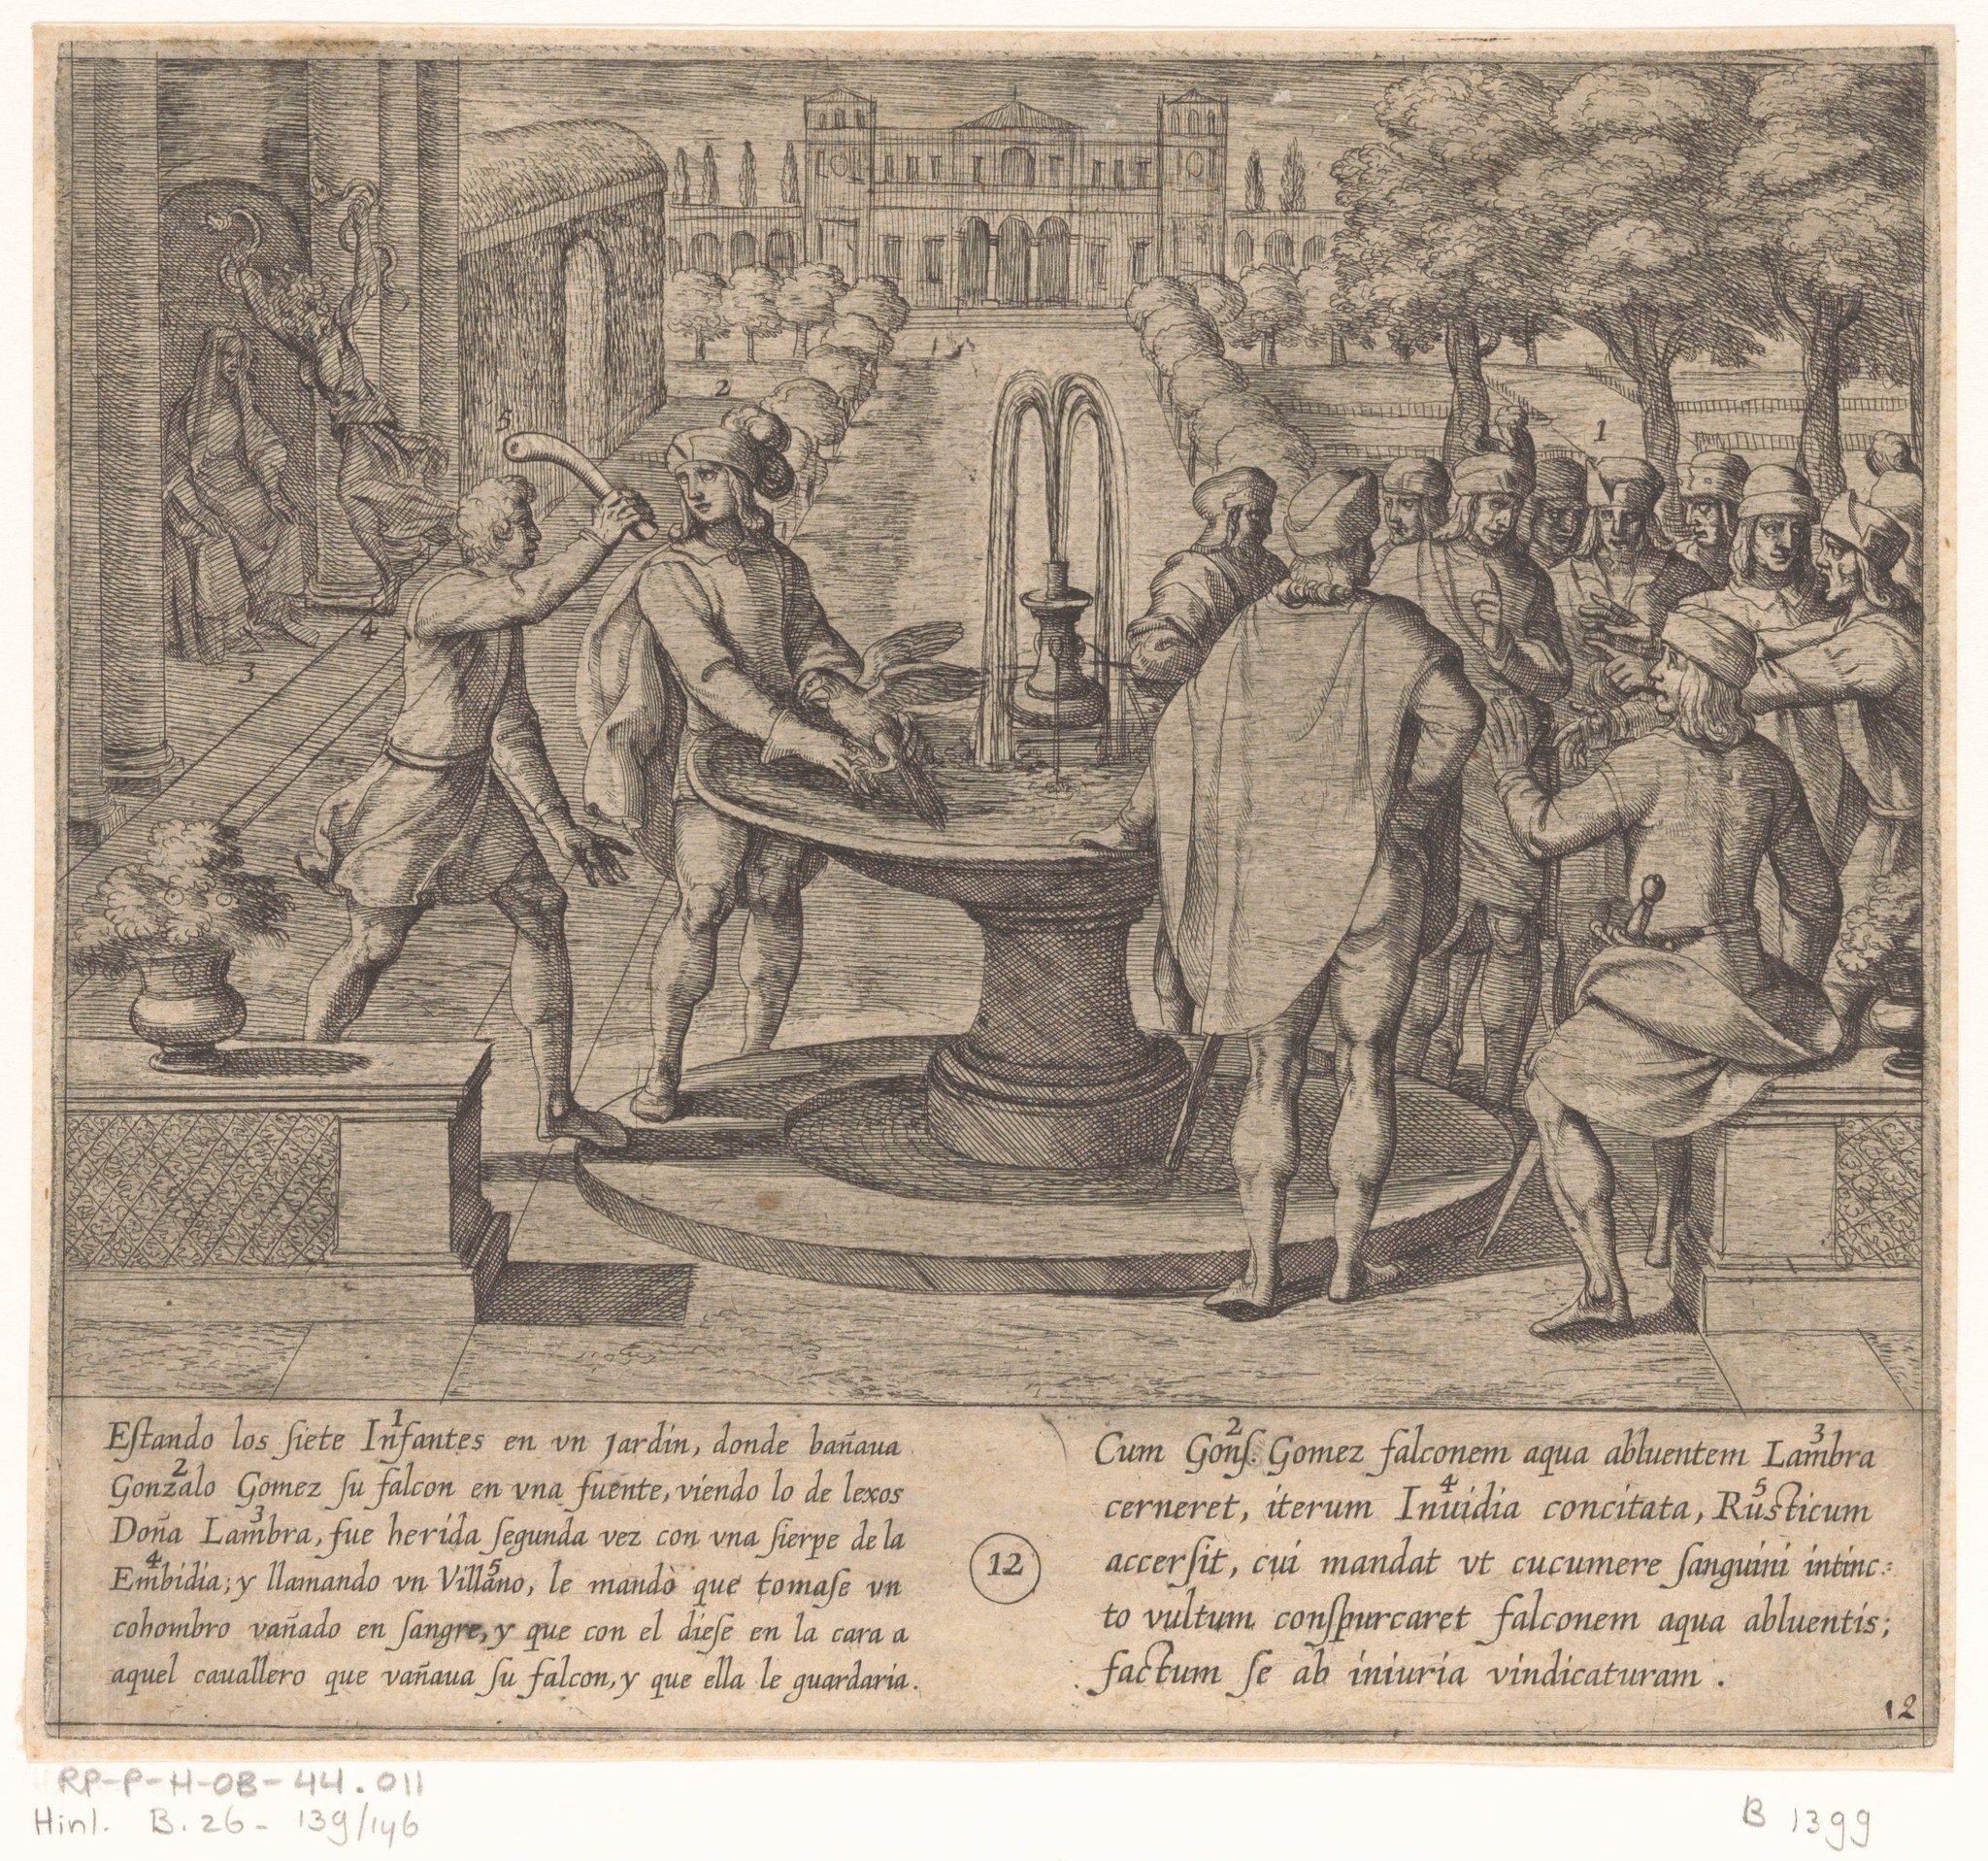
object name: print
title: Historia Septem Infantium de Lara/ Historia de los Siete Infantes de Lara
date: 1612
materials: paper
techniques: etching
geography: italy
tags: garden fountain, tales and fairy tales, surprise attack (from ambush)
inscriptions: number: ‘12’, collector's mark: Lugt 11, collector's mark: ‘Hinloopen’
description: Deze prent maakt deel uit van een reeks van 40 prenten (+ titelprent) met voorstellingen uit het volksverhaal over de zeven infanten van Lara.